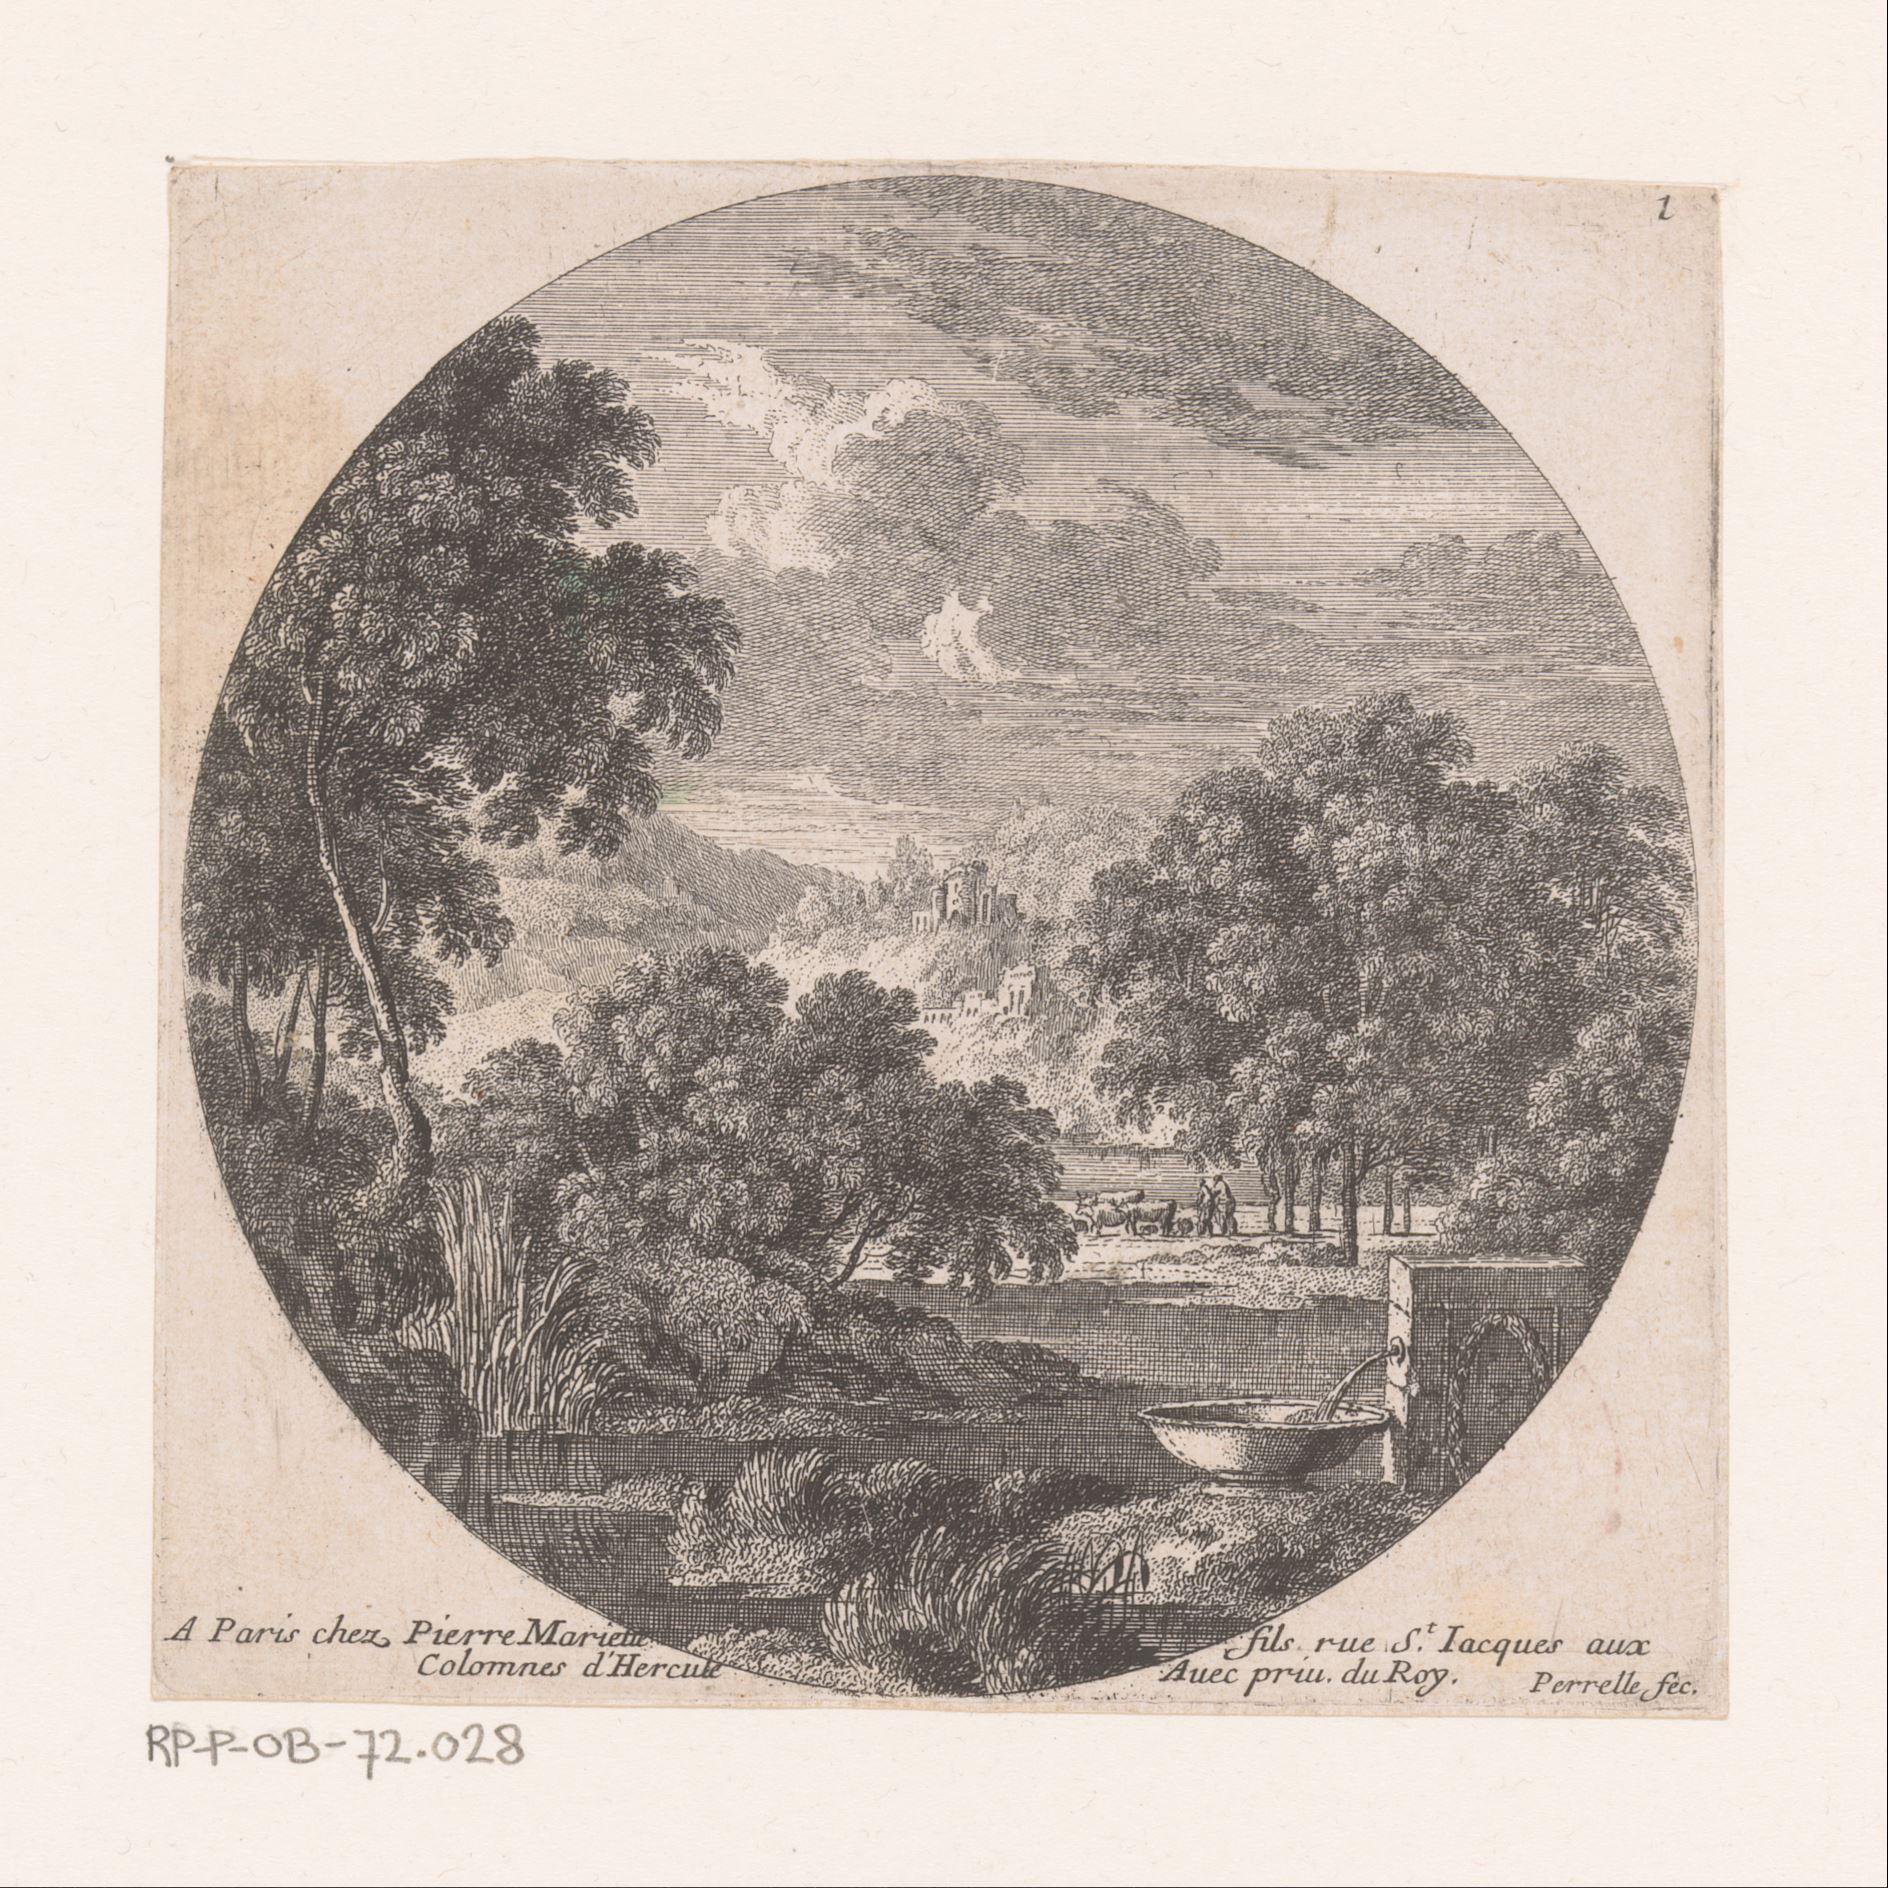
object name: print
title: Rivierlandschap met bron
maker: pierre mariette (i)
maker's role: print maker, publisher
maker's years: 1596-1657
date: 1613-1657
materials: paper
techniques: etching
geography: france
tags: well, river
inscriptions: collector's mark: Lugt 240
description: Prenten met het signatuur 'Perelle' kunnen zowel door vader Gabriel als door zonen Nicolas en Adam gemaakt zijn.